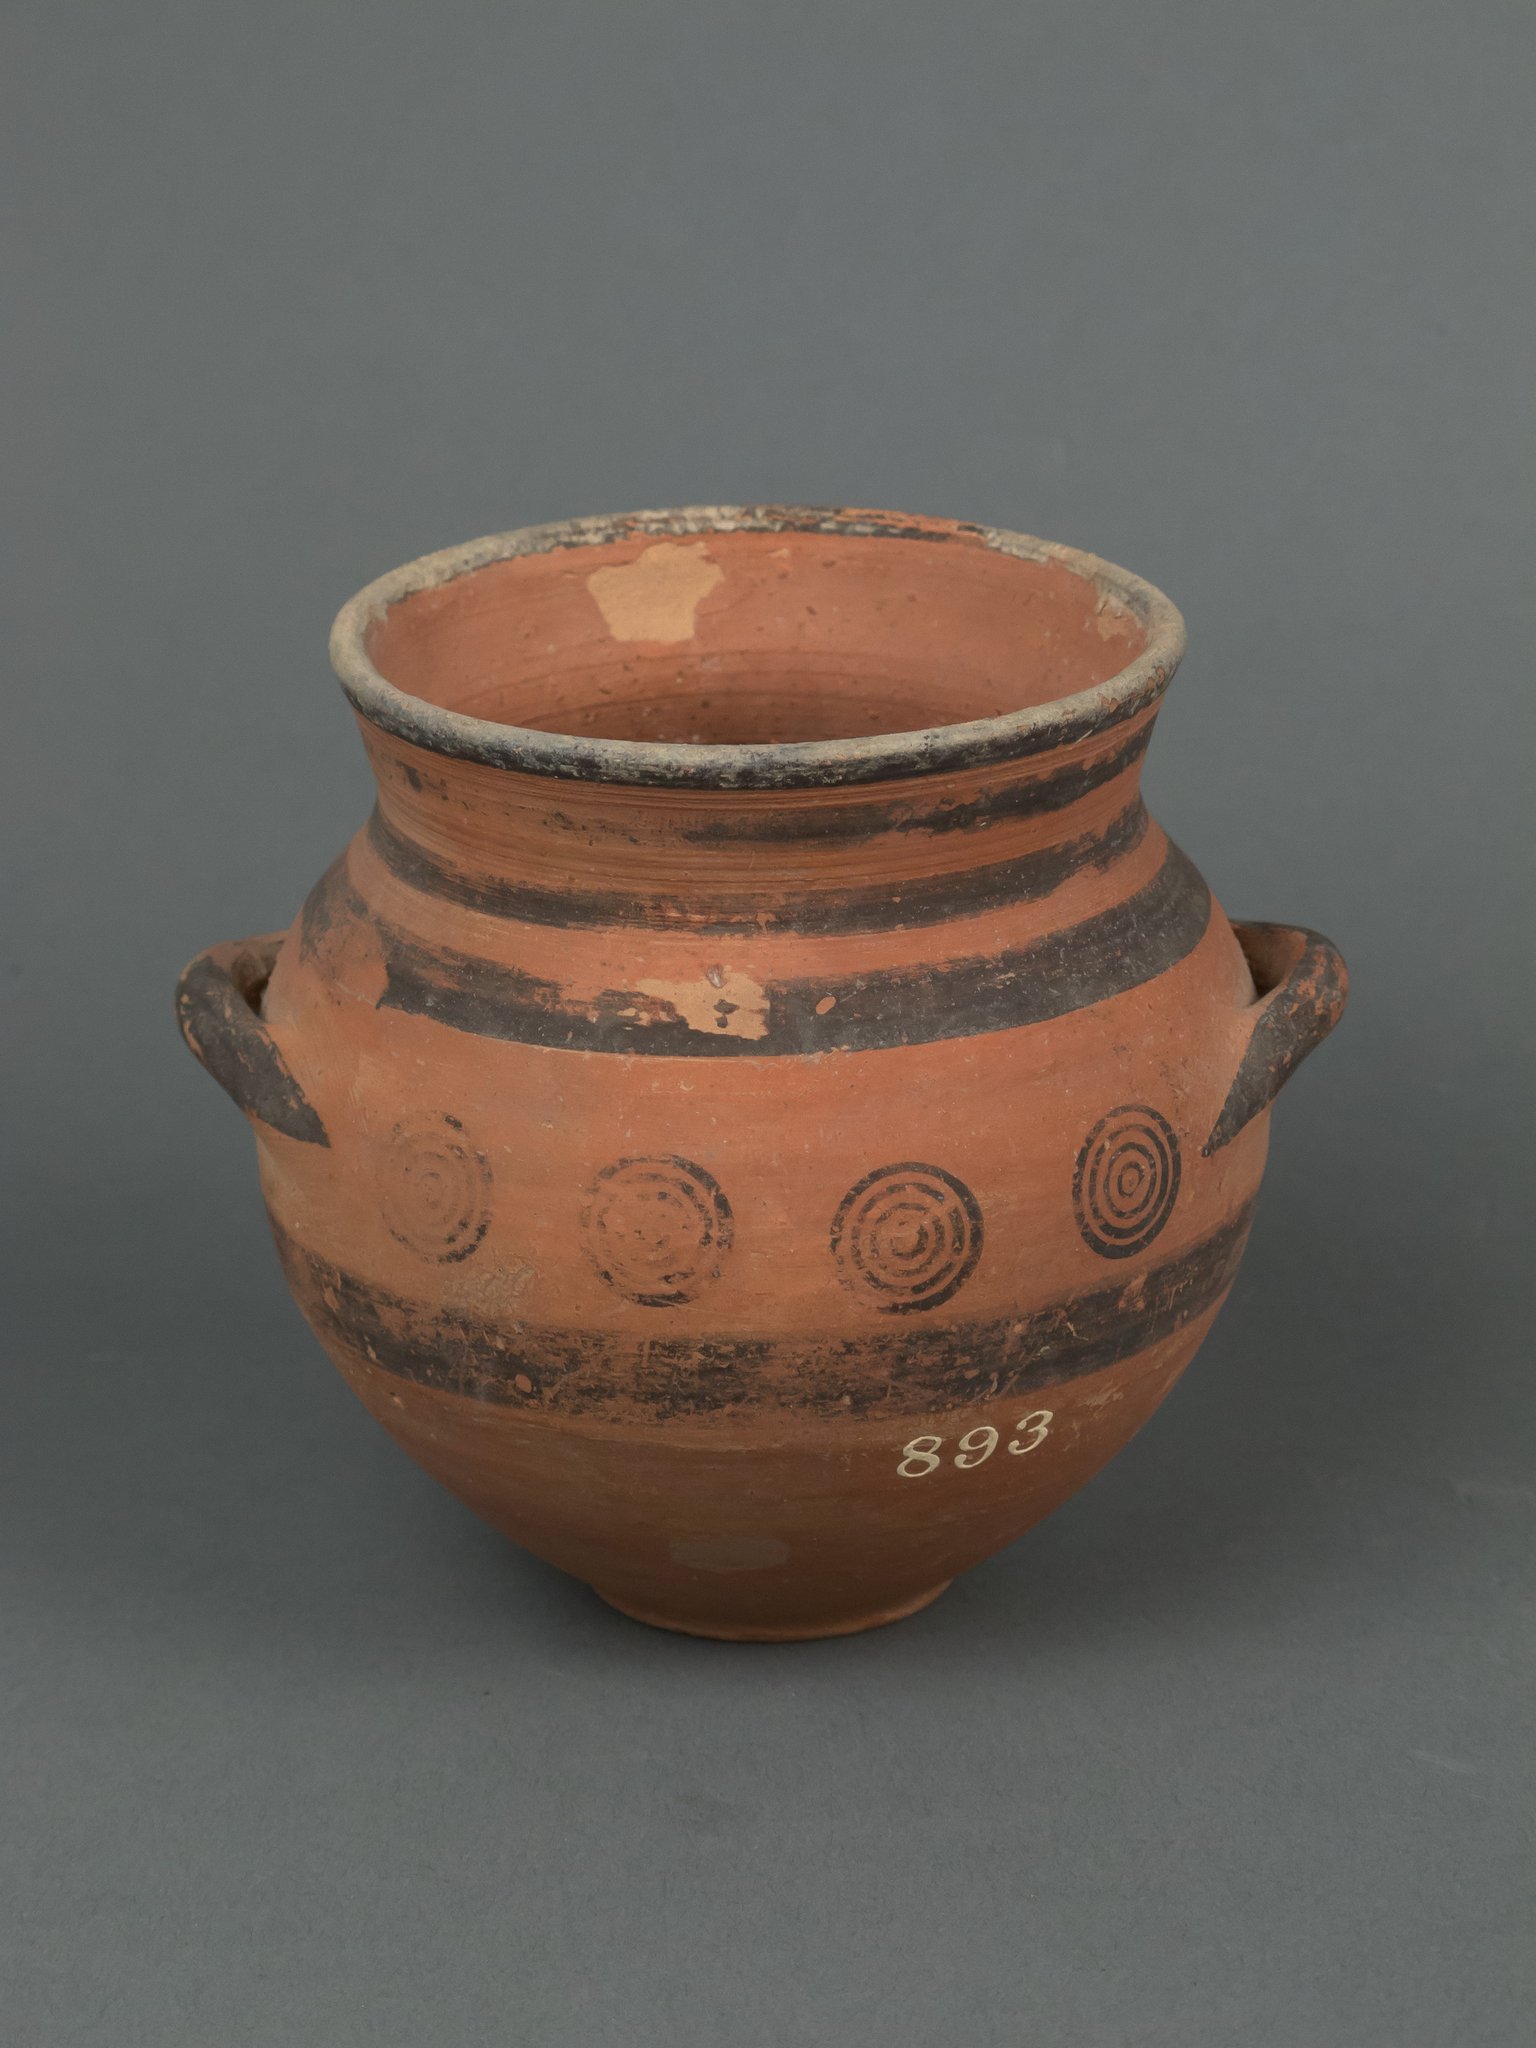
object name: amphoriskos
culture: cypriot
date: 750-600 BCE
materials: terracotta